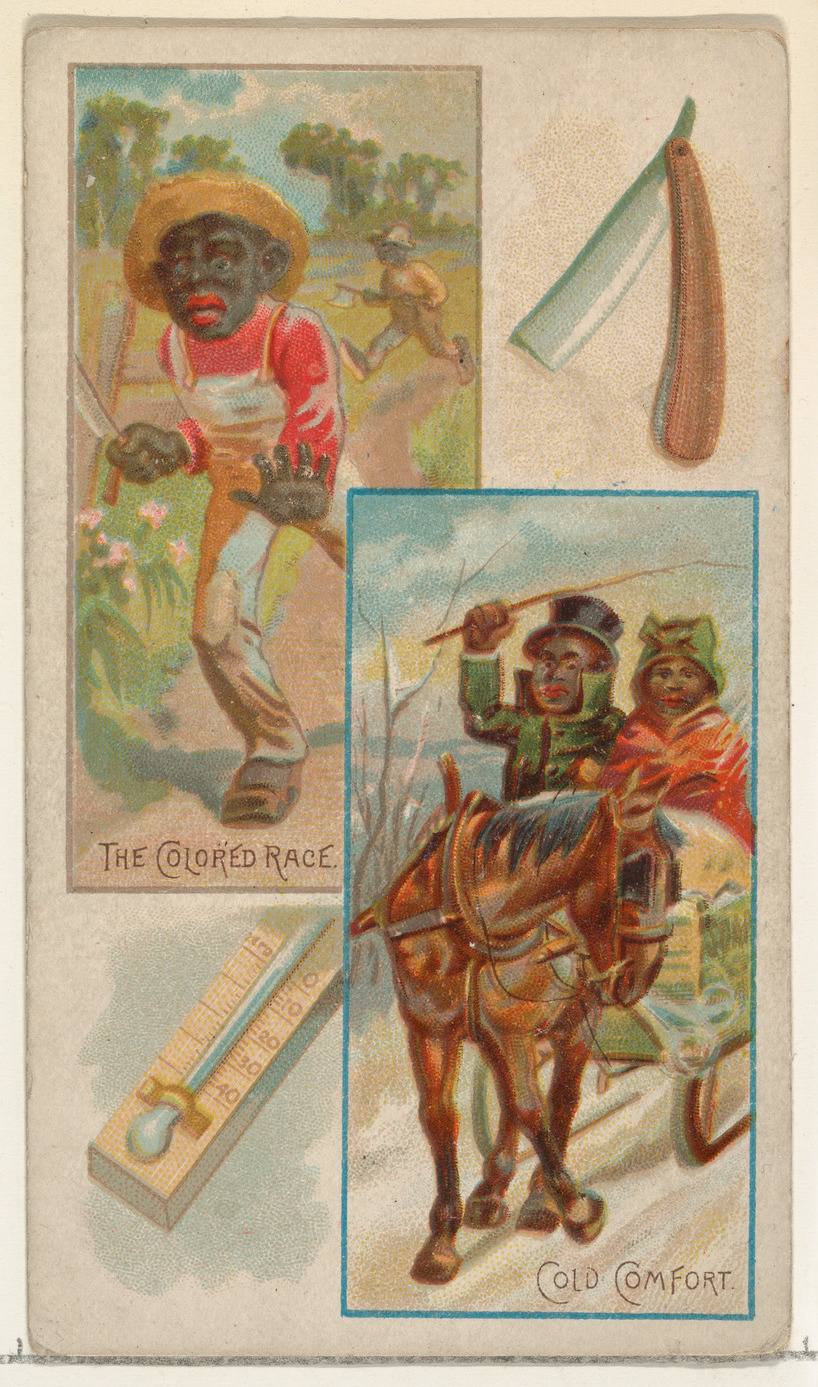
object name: print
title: The Colored Race / Cold Comfort, from the Jokes series (N118) issued by Duke Sons & Co. to promote Honest Long Cut Tobacco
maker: w. duke, sons & co.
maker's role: publisher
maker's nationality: american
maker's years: 1870-1920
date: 1891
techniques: color lithograph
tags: men,horses